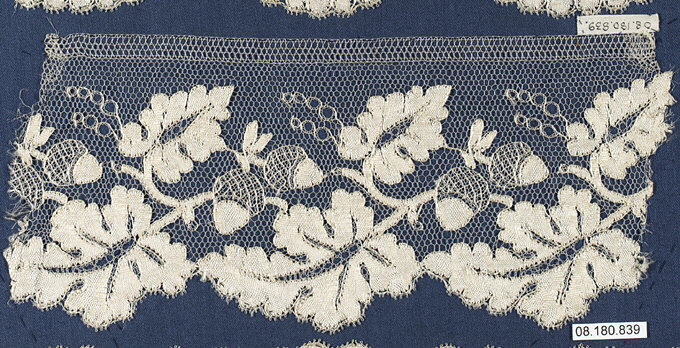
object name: piece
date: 1801-1900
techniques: lace